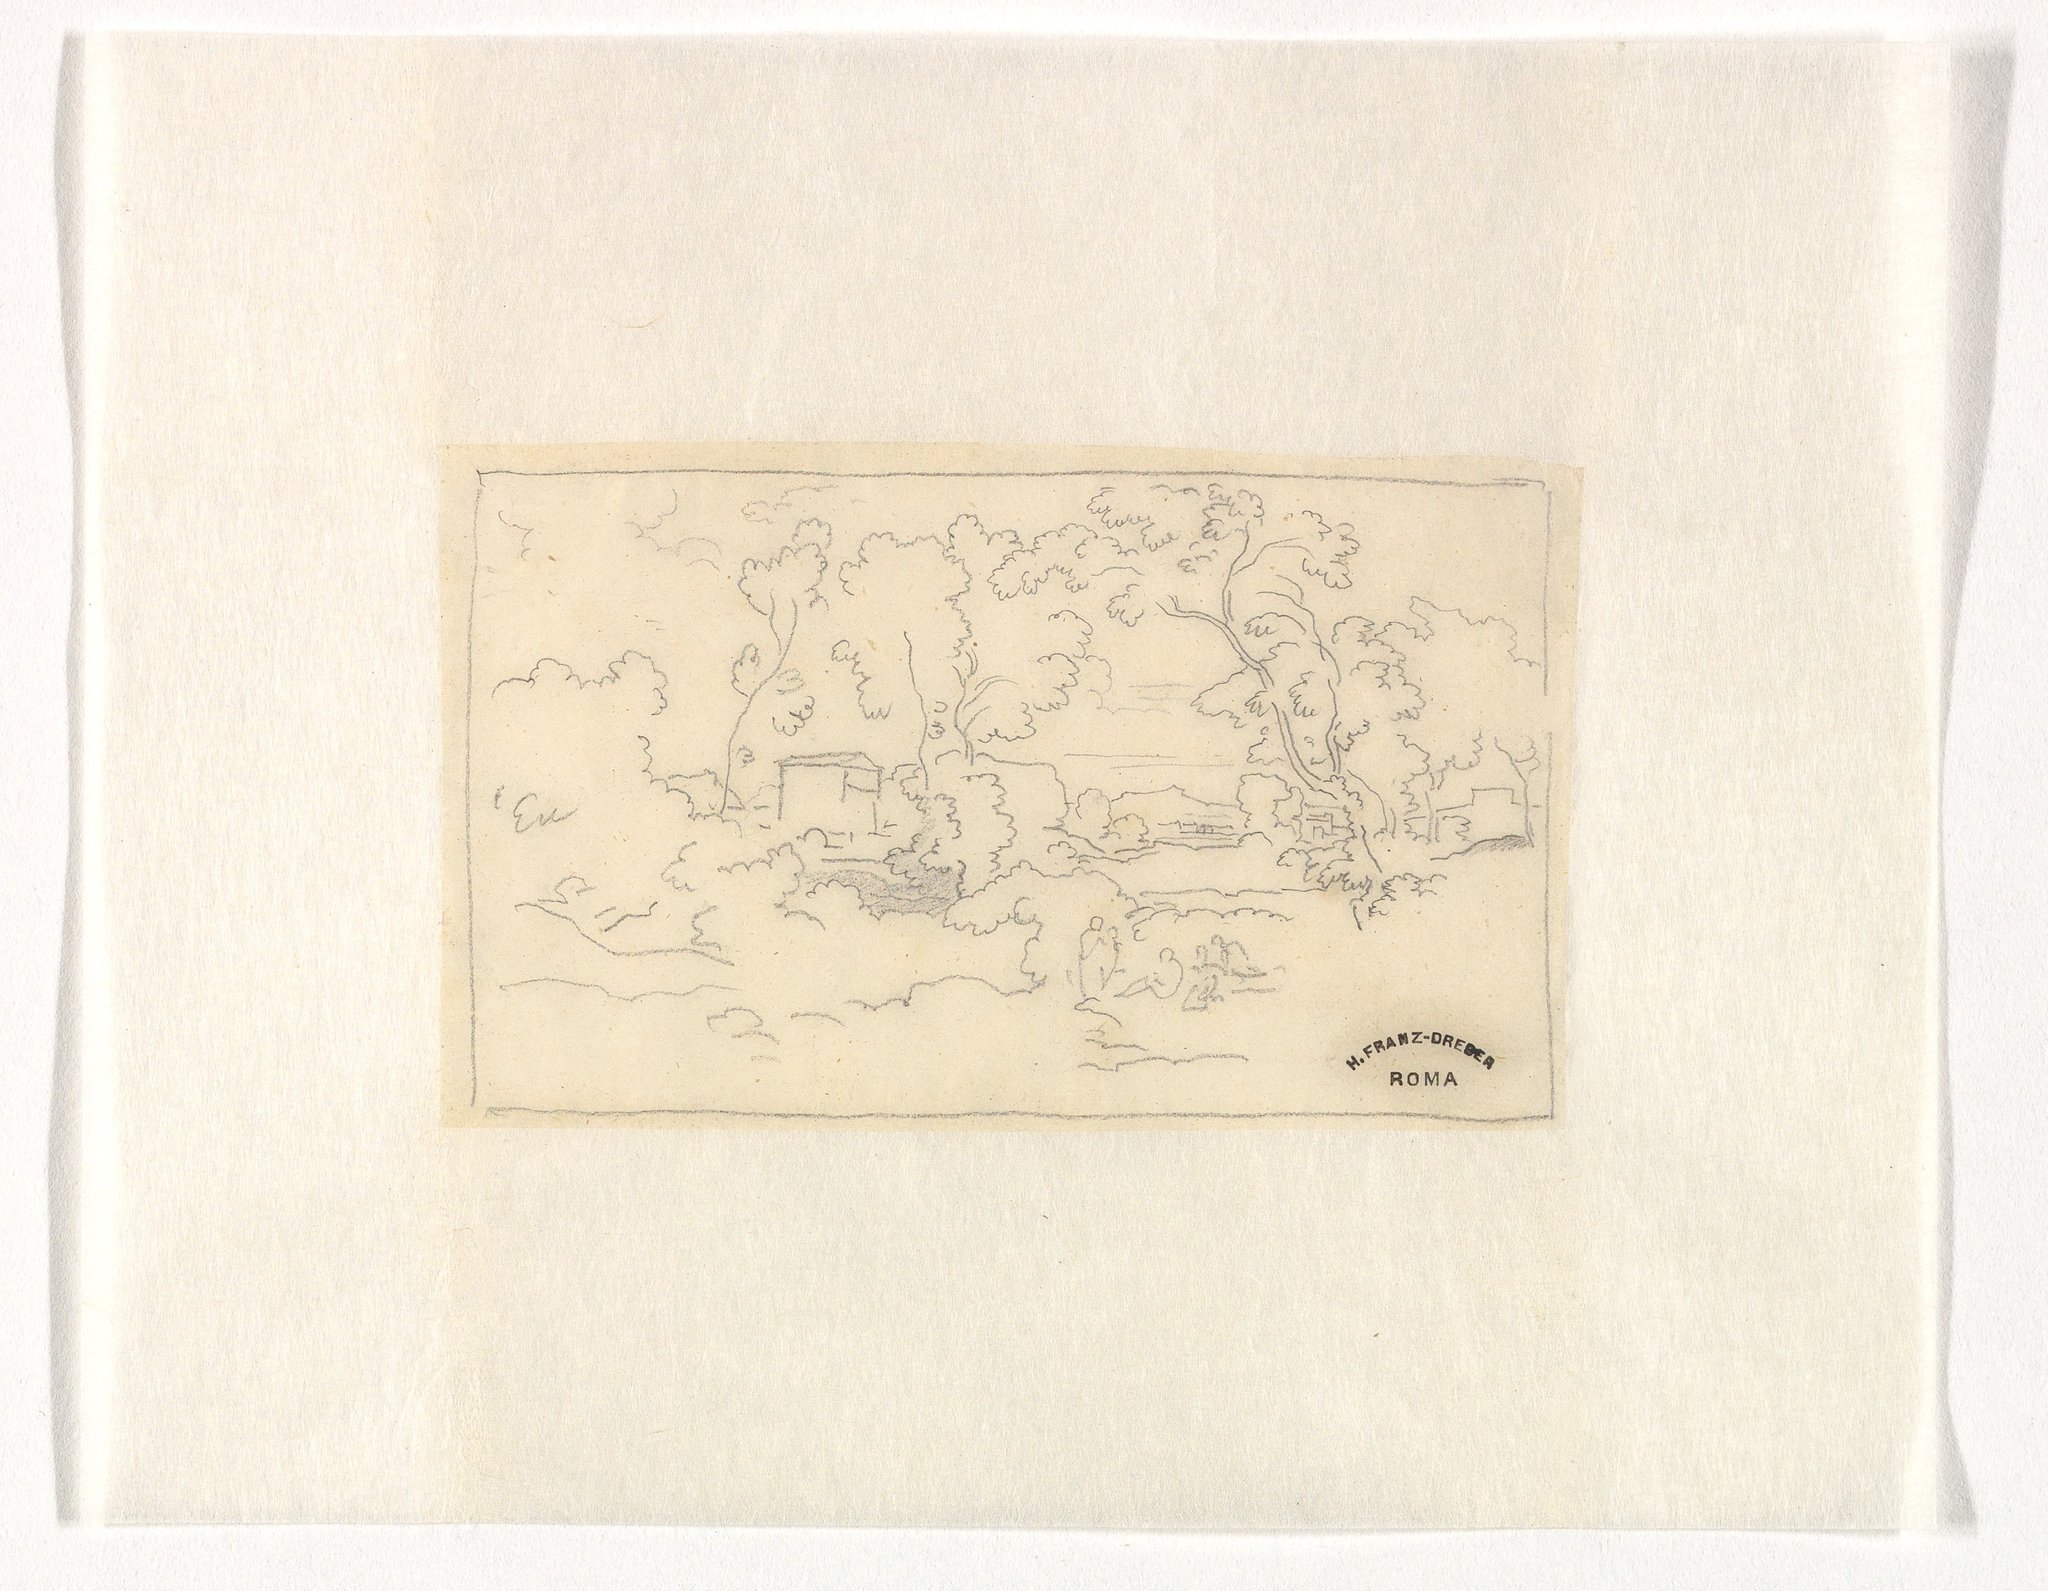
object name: drawing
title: Southern landscape with a building and figures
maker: heinrich dreber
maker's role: artist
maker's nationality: german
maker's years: 1822-1875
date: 1855-1858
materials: graphite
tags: landscapes